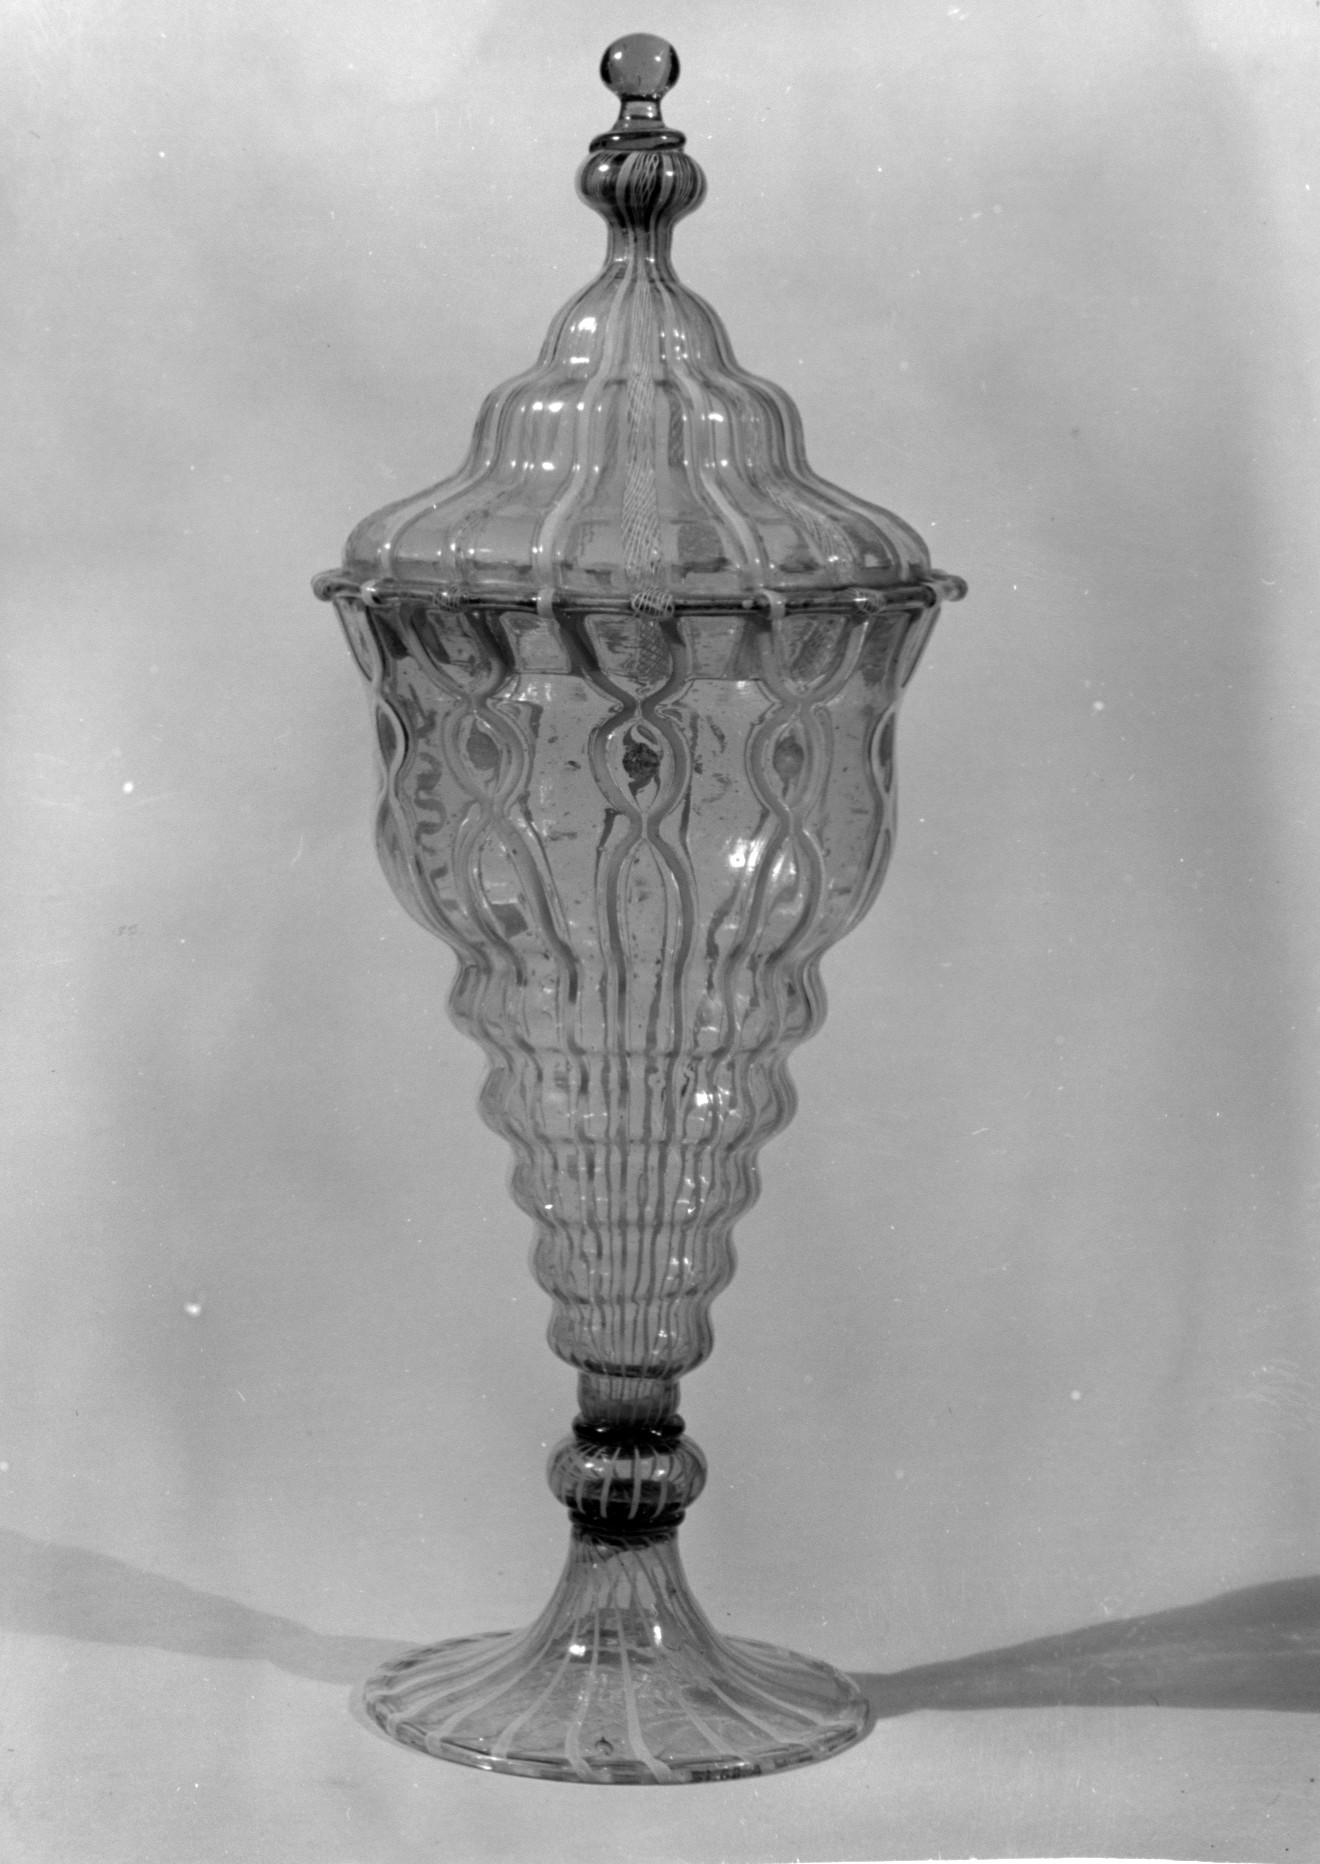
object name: cup with cover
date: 1601-1633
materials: glass